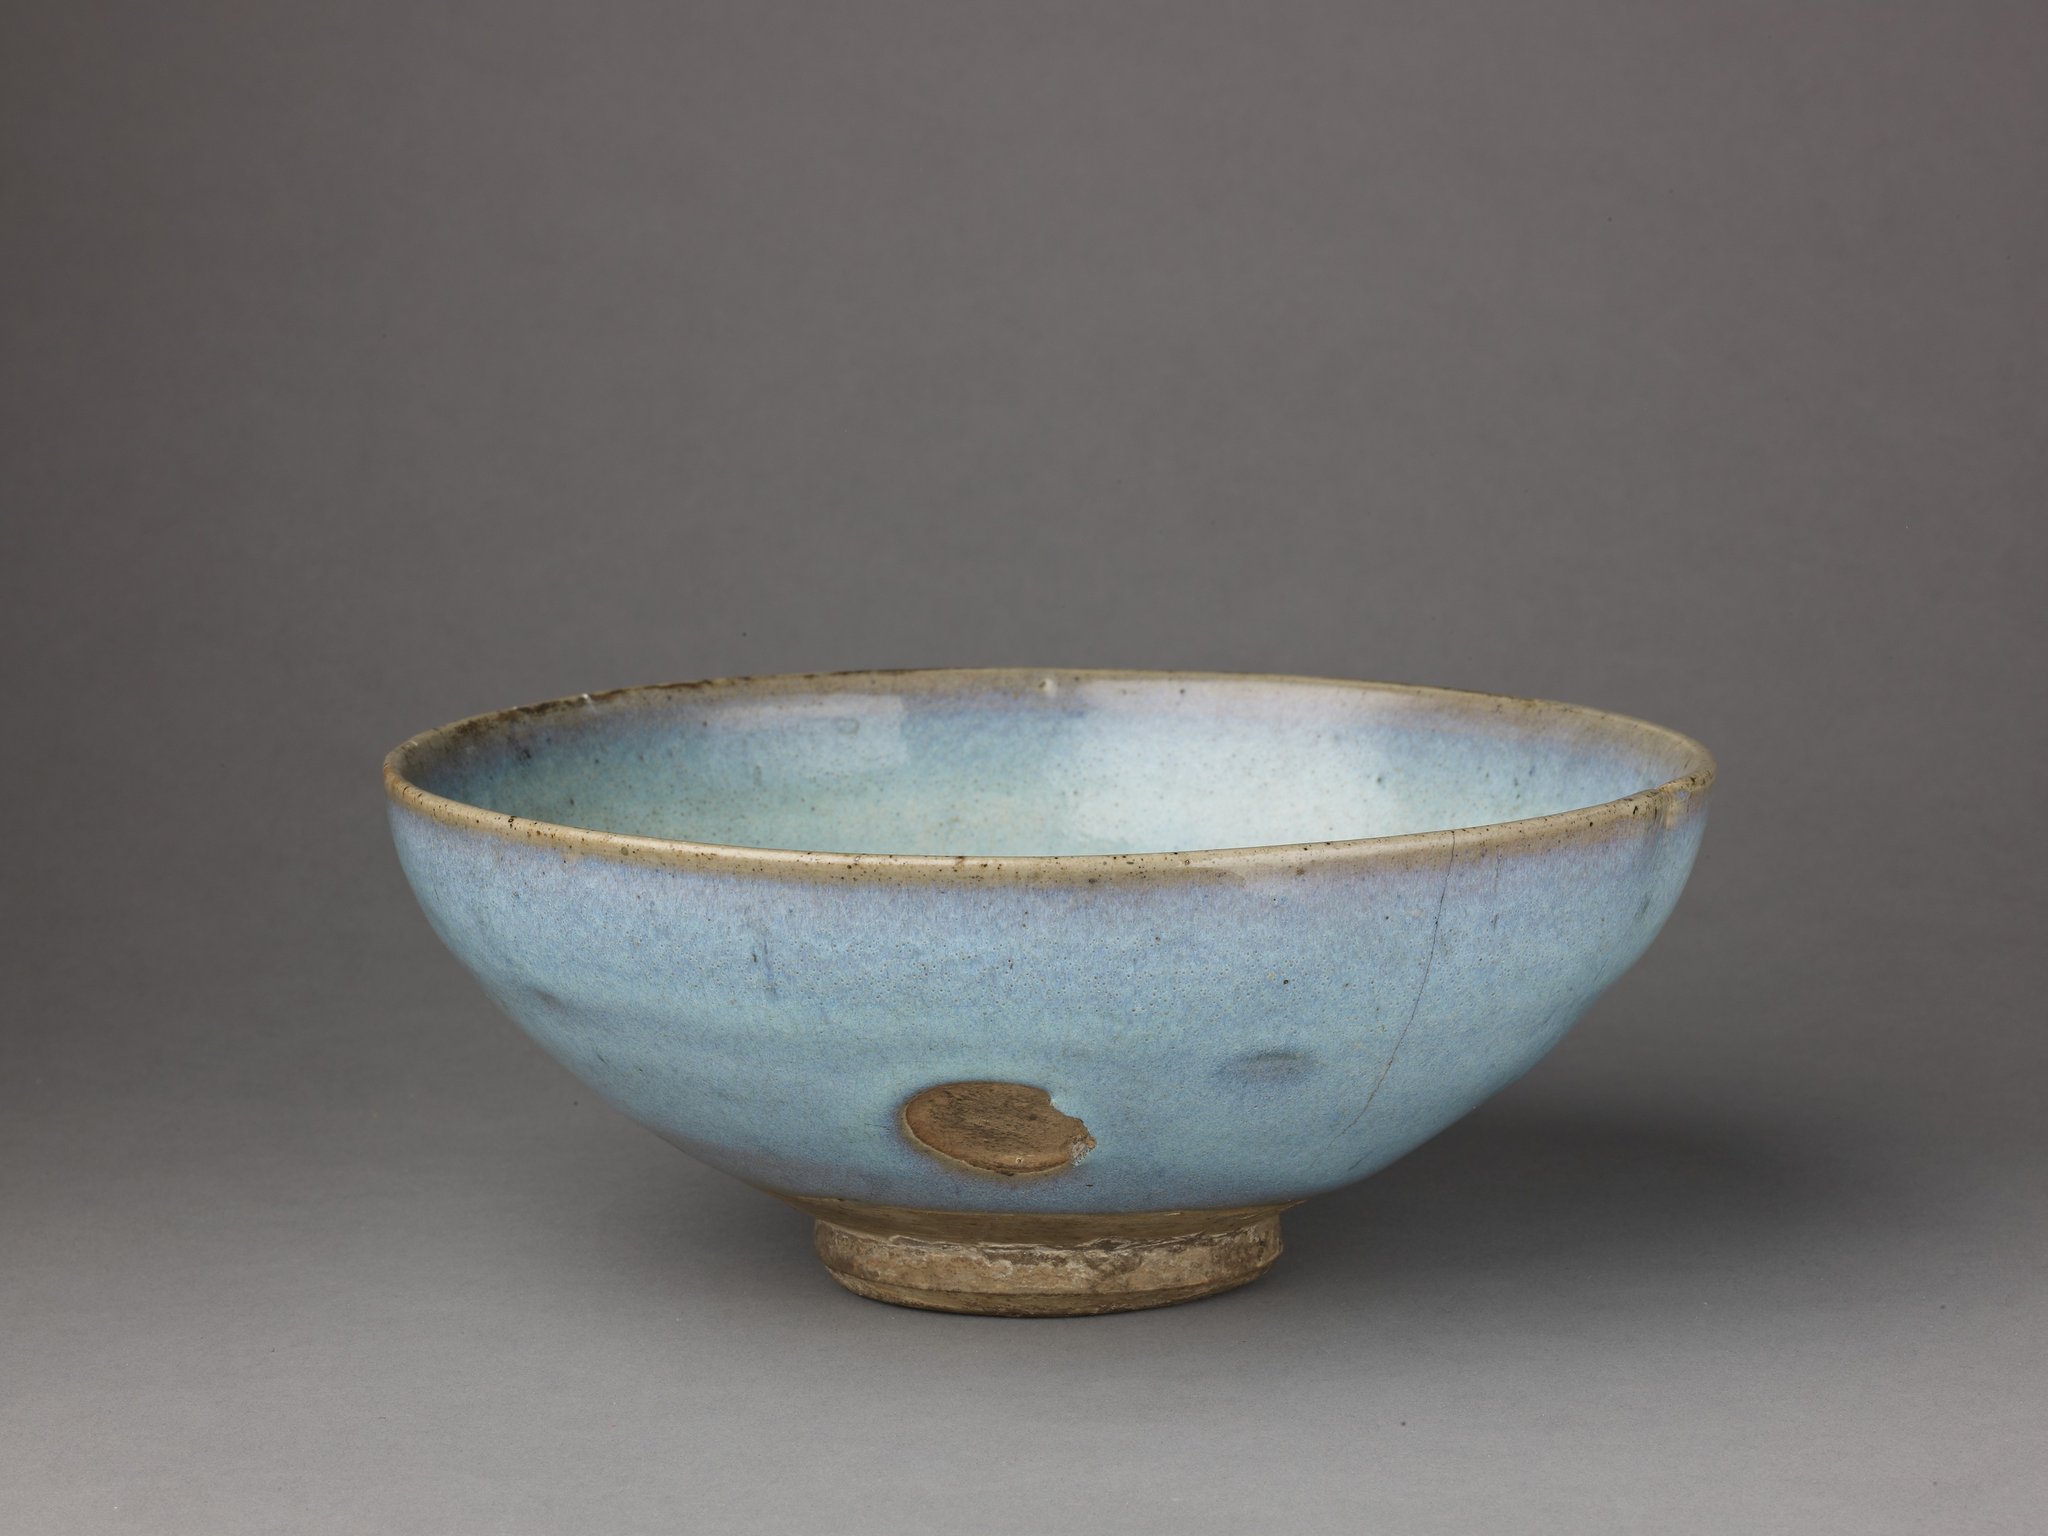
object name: bowl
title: Deep bowl, Jun ware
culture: chinese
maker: chinese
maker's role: artist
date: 1201-1400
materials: glaze, stoneware